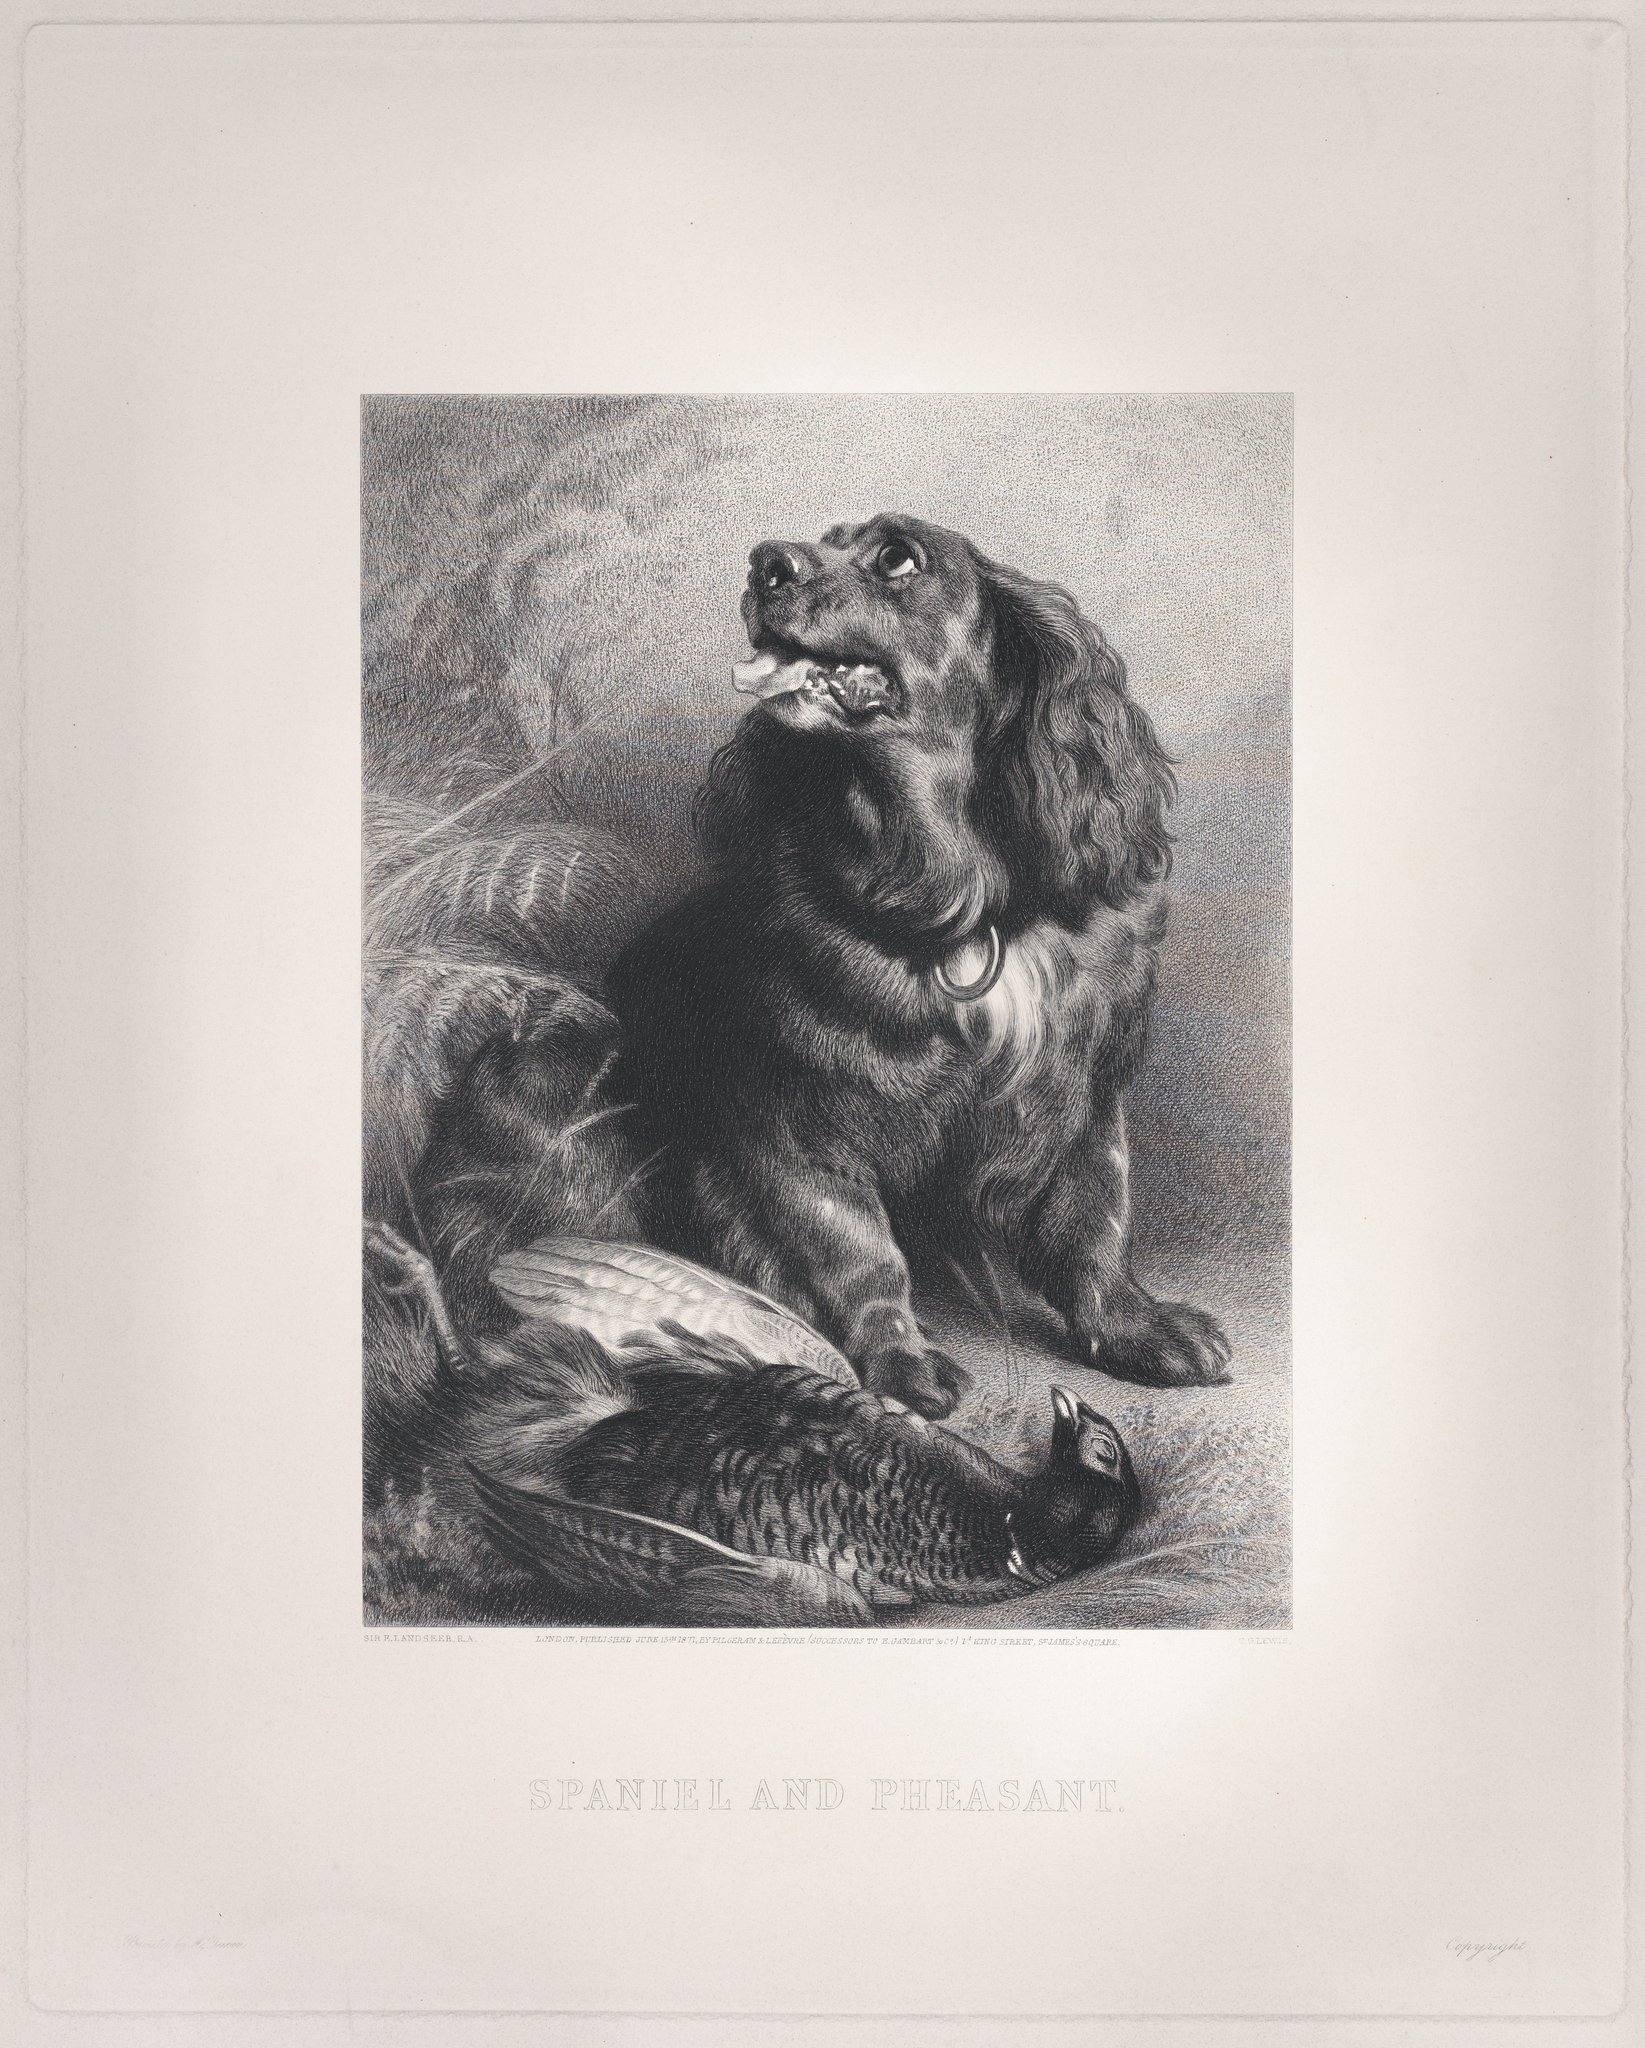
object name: print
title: Spaniel and Pheasant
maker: sir edwin henry landseer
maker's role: artist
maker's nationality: british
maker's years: 1802-1873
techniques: printmaking, engraving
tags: birds,dogs